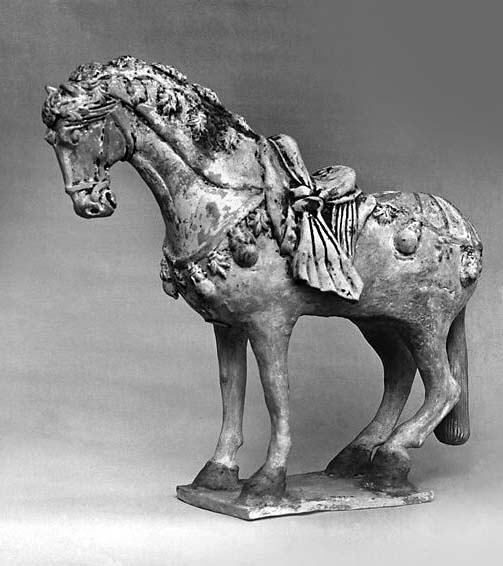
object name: figure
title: Horse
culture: chinese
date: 701-900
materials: earthenware, pigment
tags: horses